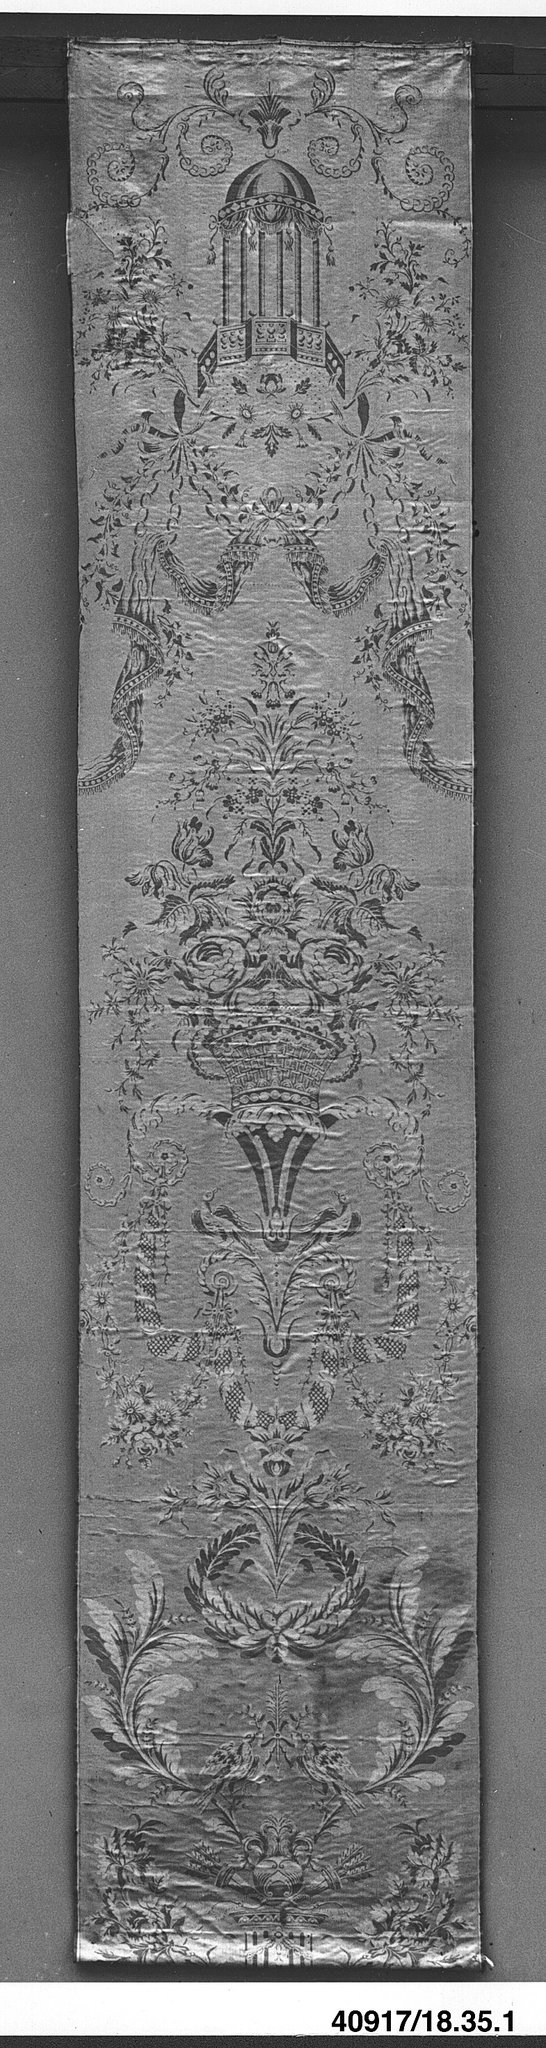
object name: panel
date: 1701-1800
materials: silk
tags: flowers,leaves